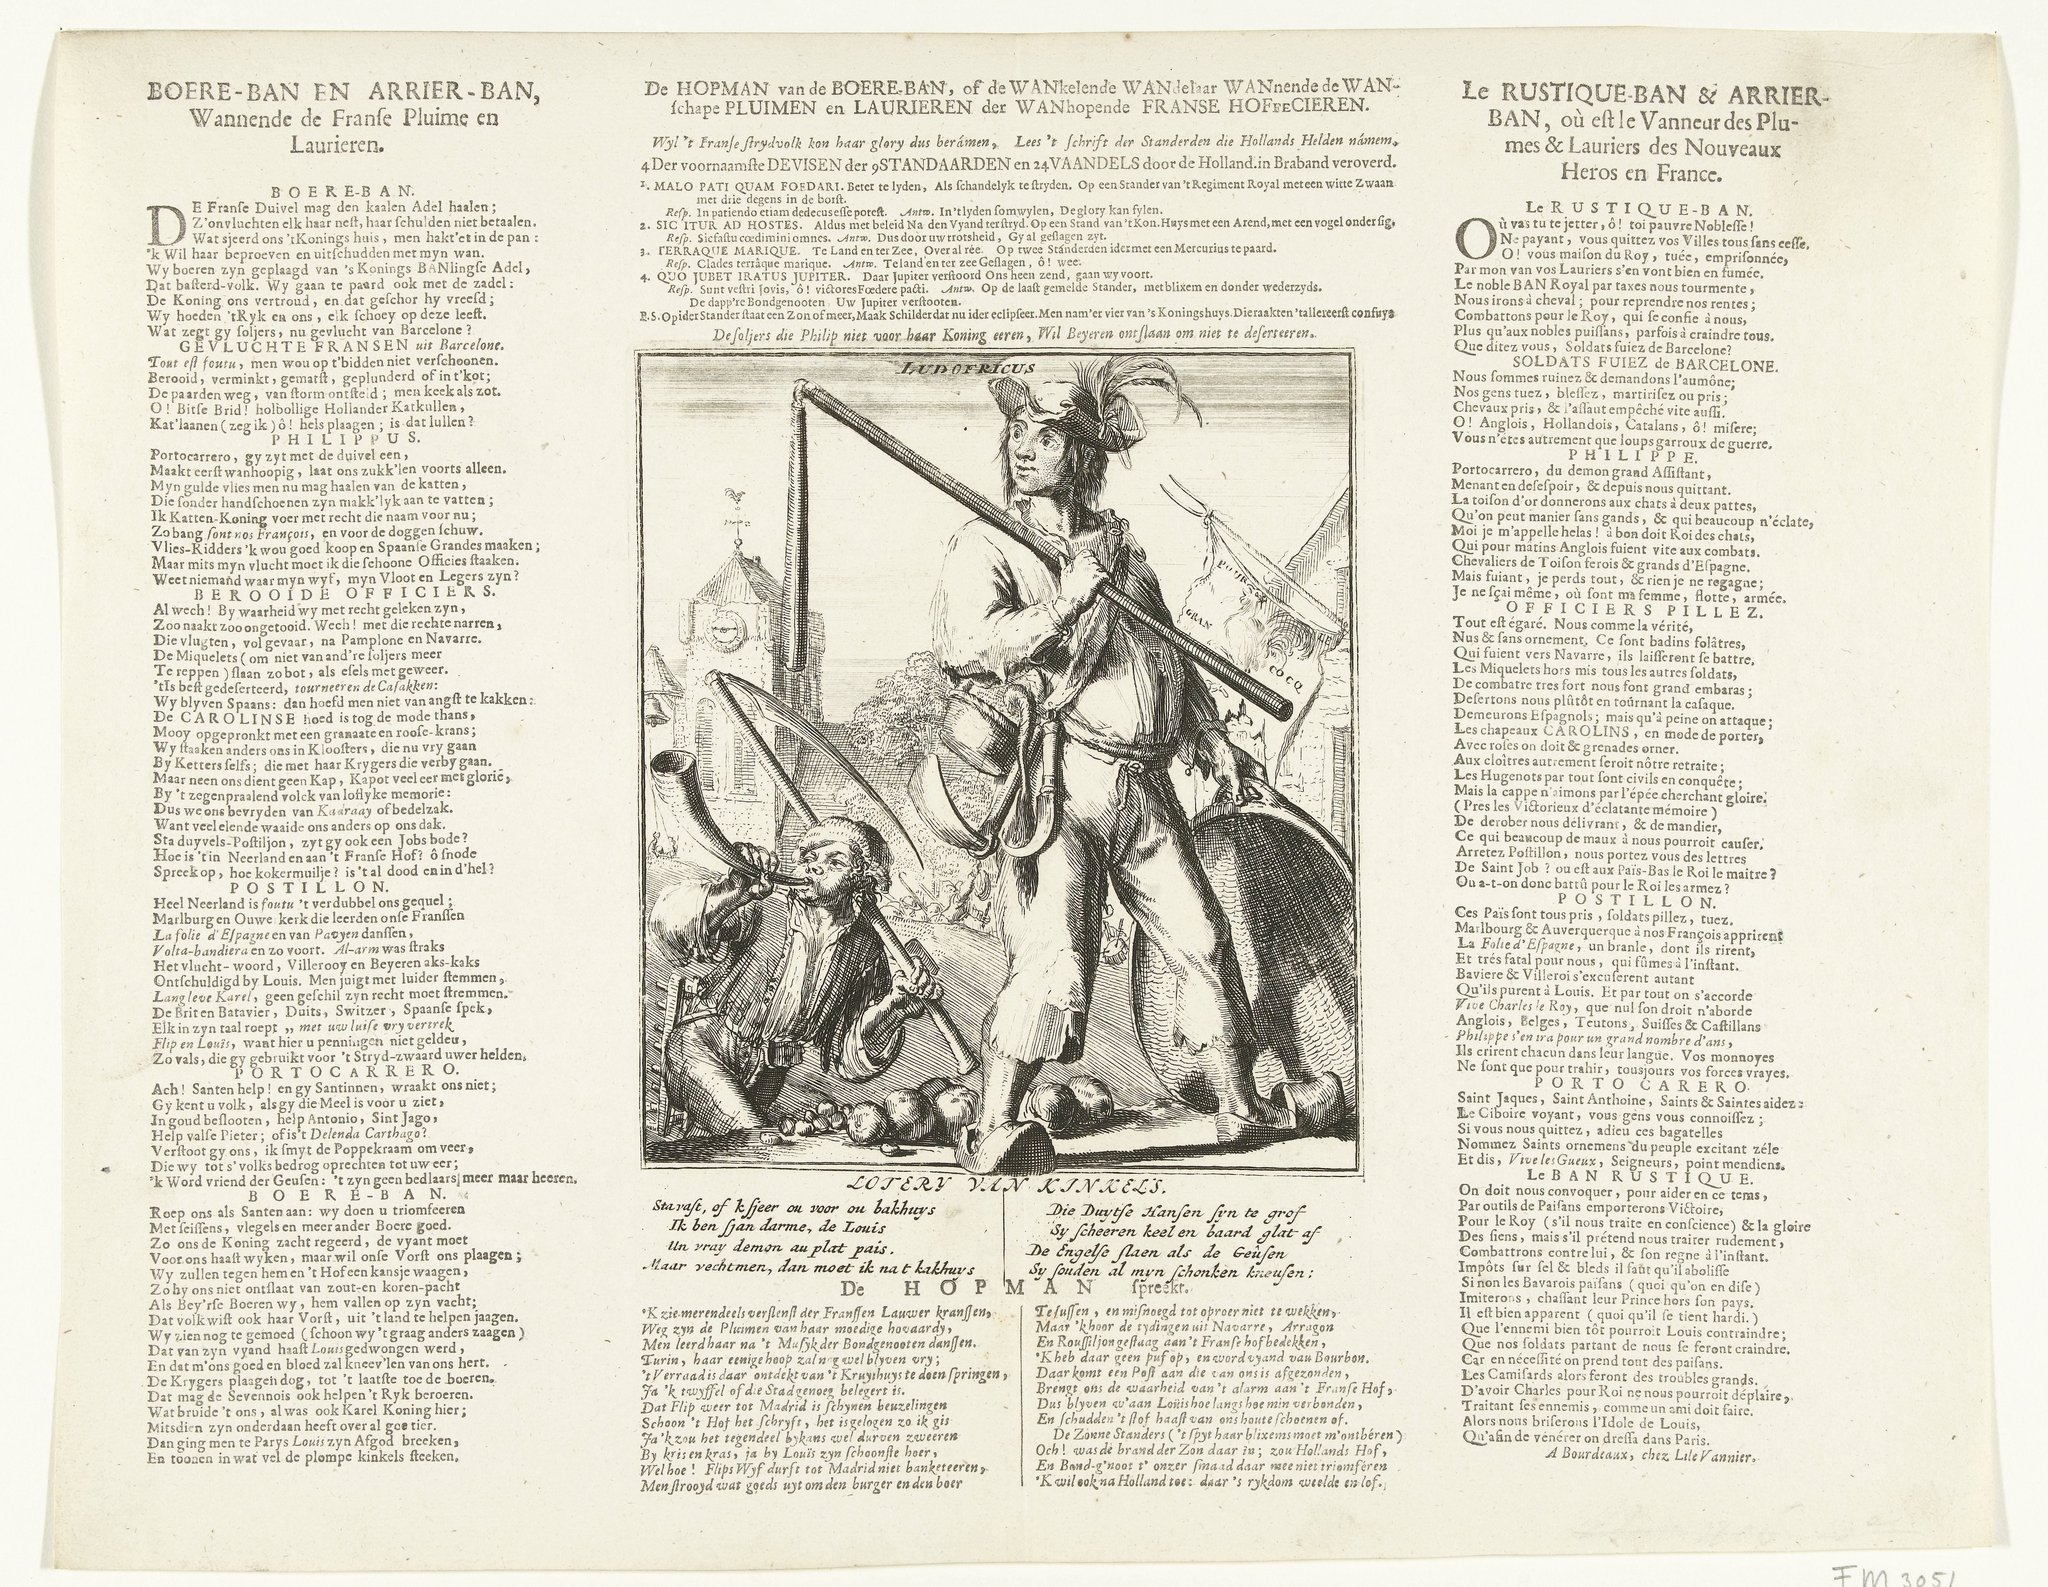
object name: cartoon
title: Koninklijke Almanach van 1701 / 't Lusthof van Momus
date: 1706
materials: paper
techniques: etching, letterpress printing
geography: amsterdam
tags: farmers, political caricatures and satires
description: Spotprent op de Franse boerensoldaten die als het op vechten aankomt vluchten naar het kakhuis. Staande Franse boer met vlegel en wan, achter hem blaast een boer met een zeis op een hoorn. In het onderschrift een vers van twee keer vier regels in het Nederlands. Op het blad onder en naast de plaat verzen gedrukt in het Frans en Nederlands. Onderdeel van een reeks van 19 spotprenten op de Fransen en bondgenoten uit het jaar 1706.